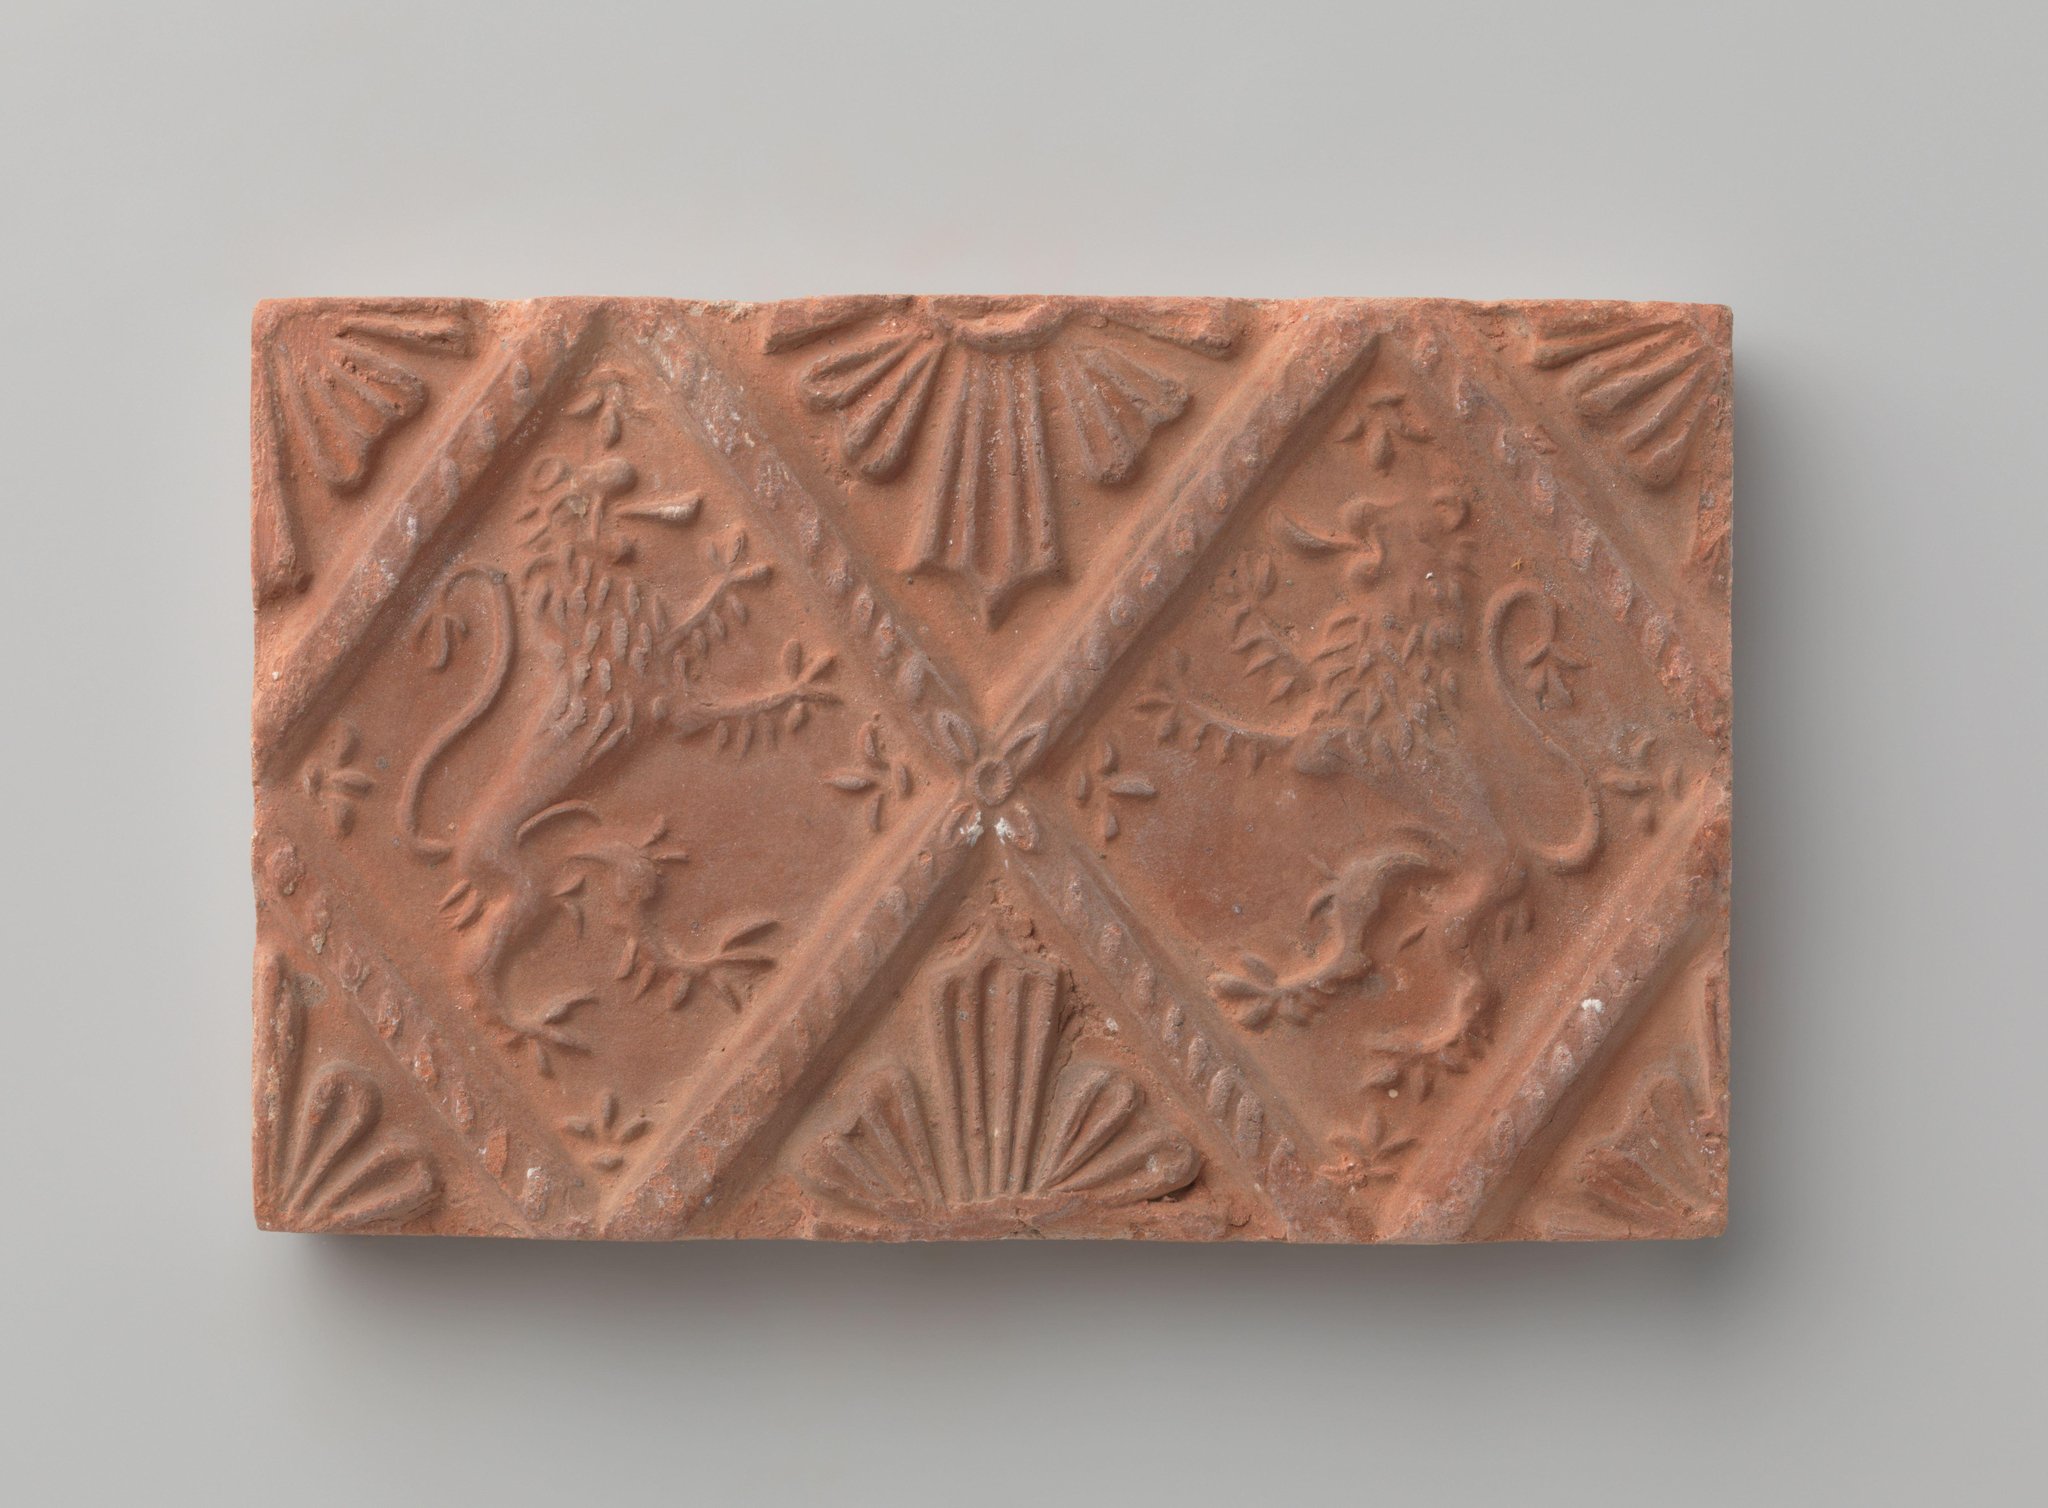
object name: hearthstone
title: Haardsteen met voorstelling van twee klimmende leeuwen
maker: Anonymous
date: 1875-1900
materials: earthenware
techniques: printing, firing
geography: netherlands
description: Haardsteen met voorstelling van twee klimmende leeuwen, geplaatst in geprofileerde ruit. De halve ruiten aan de boven- en onderkant zijn opgevuld met stermotief.